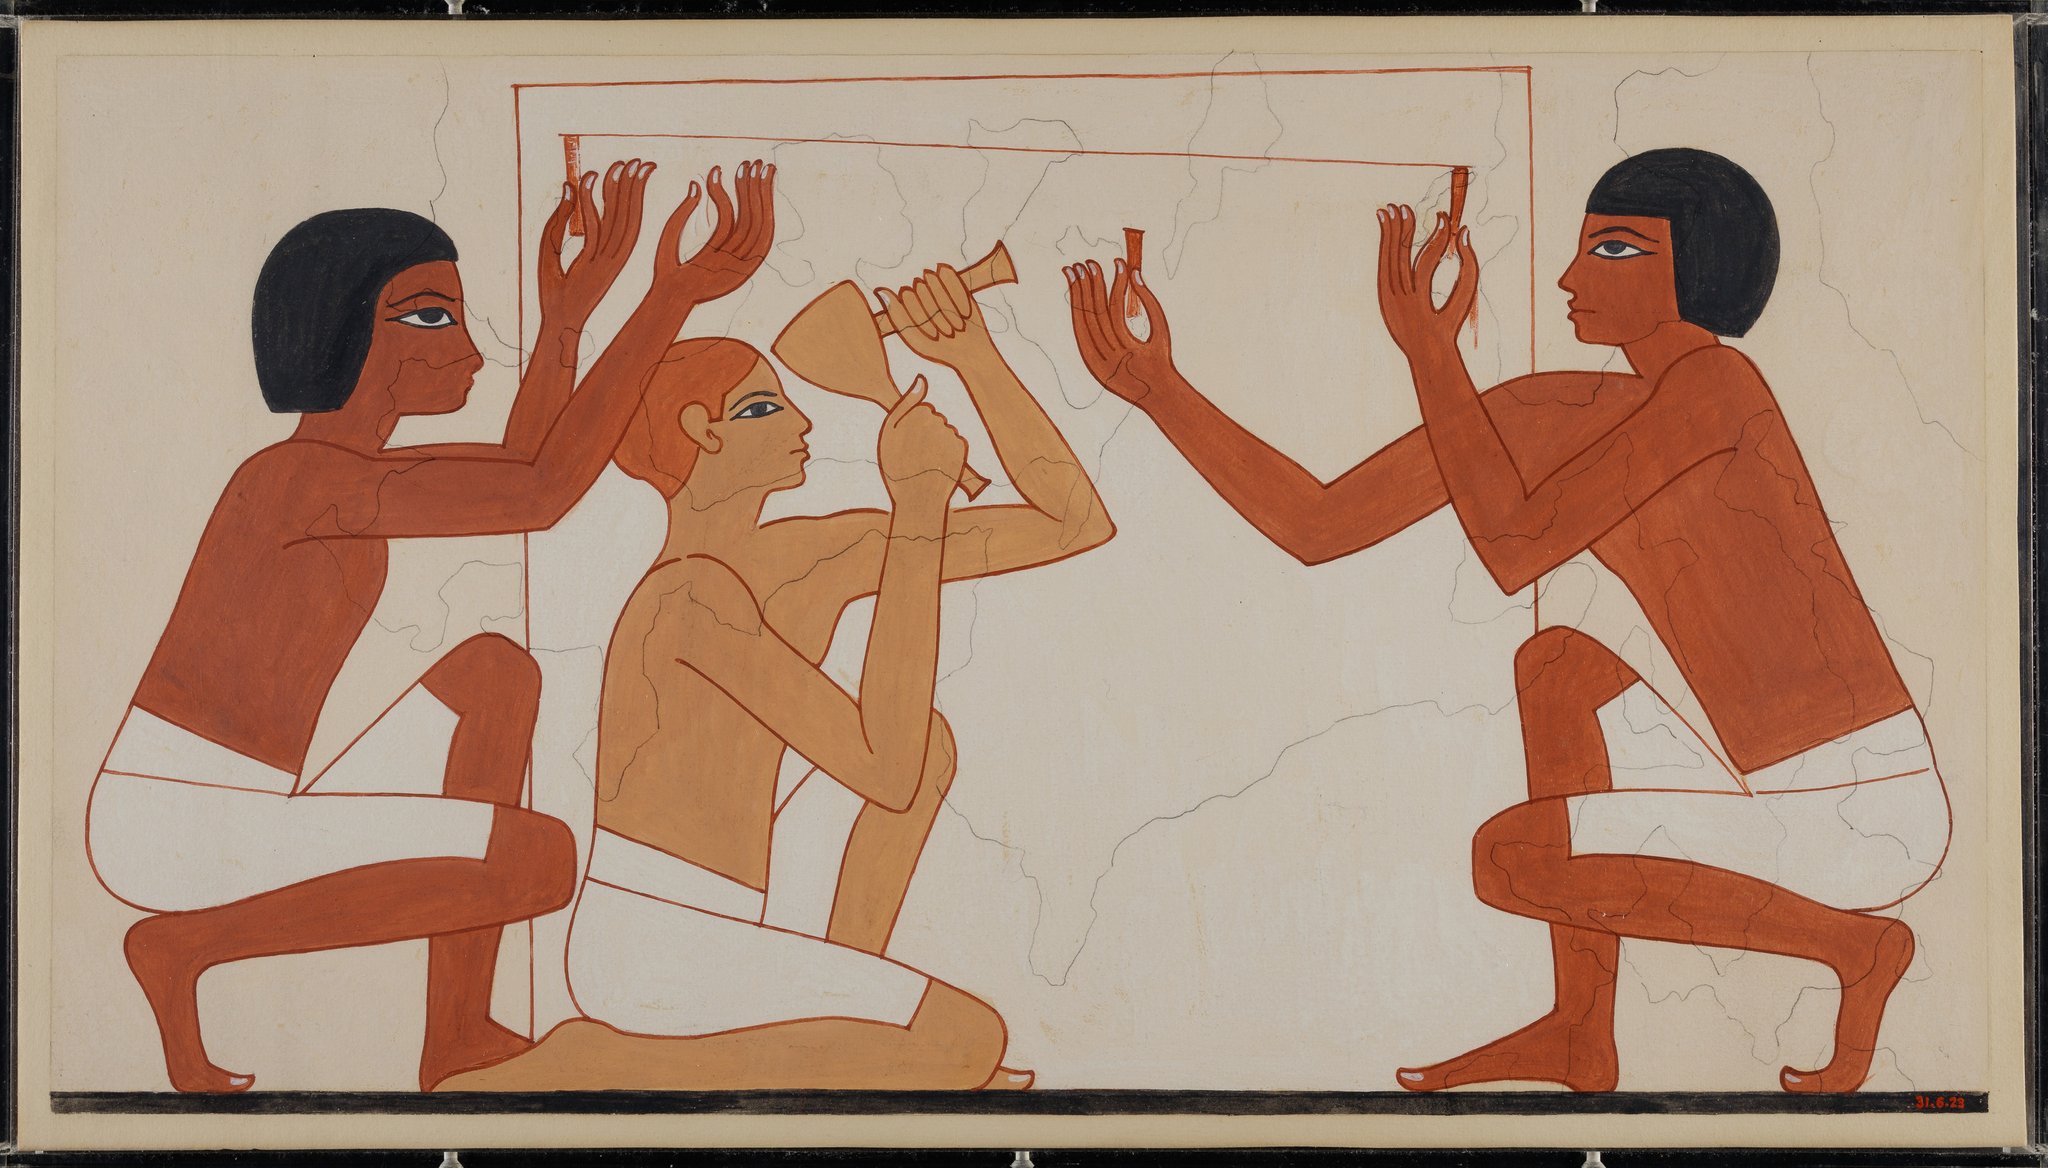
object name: restored copy, rekhmire tt 100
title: Masons Squaring a Block, Tomb of Rekhmire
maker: nina de garis davies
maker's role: artist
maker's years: 1881-1965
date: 1479-1425 BCE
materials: paper, paint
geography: egypt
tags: men,working